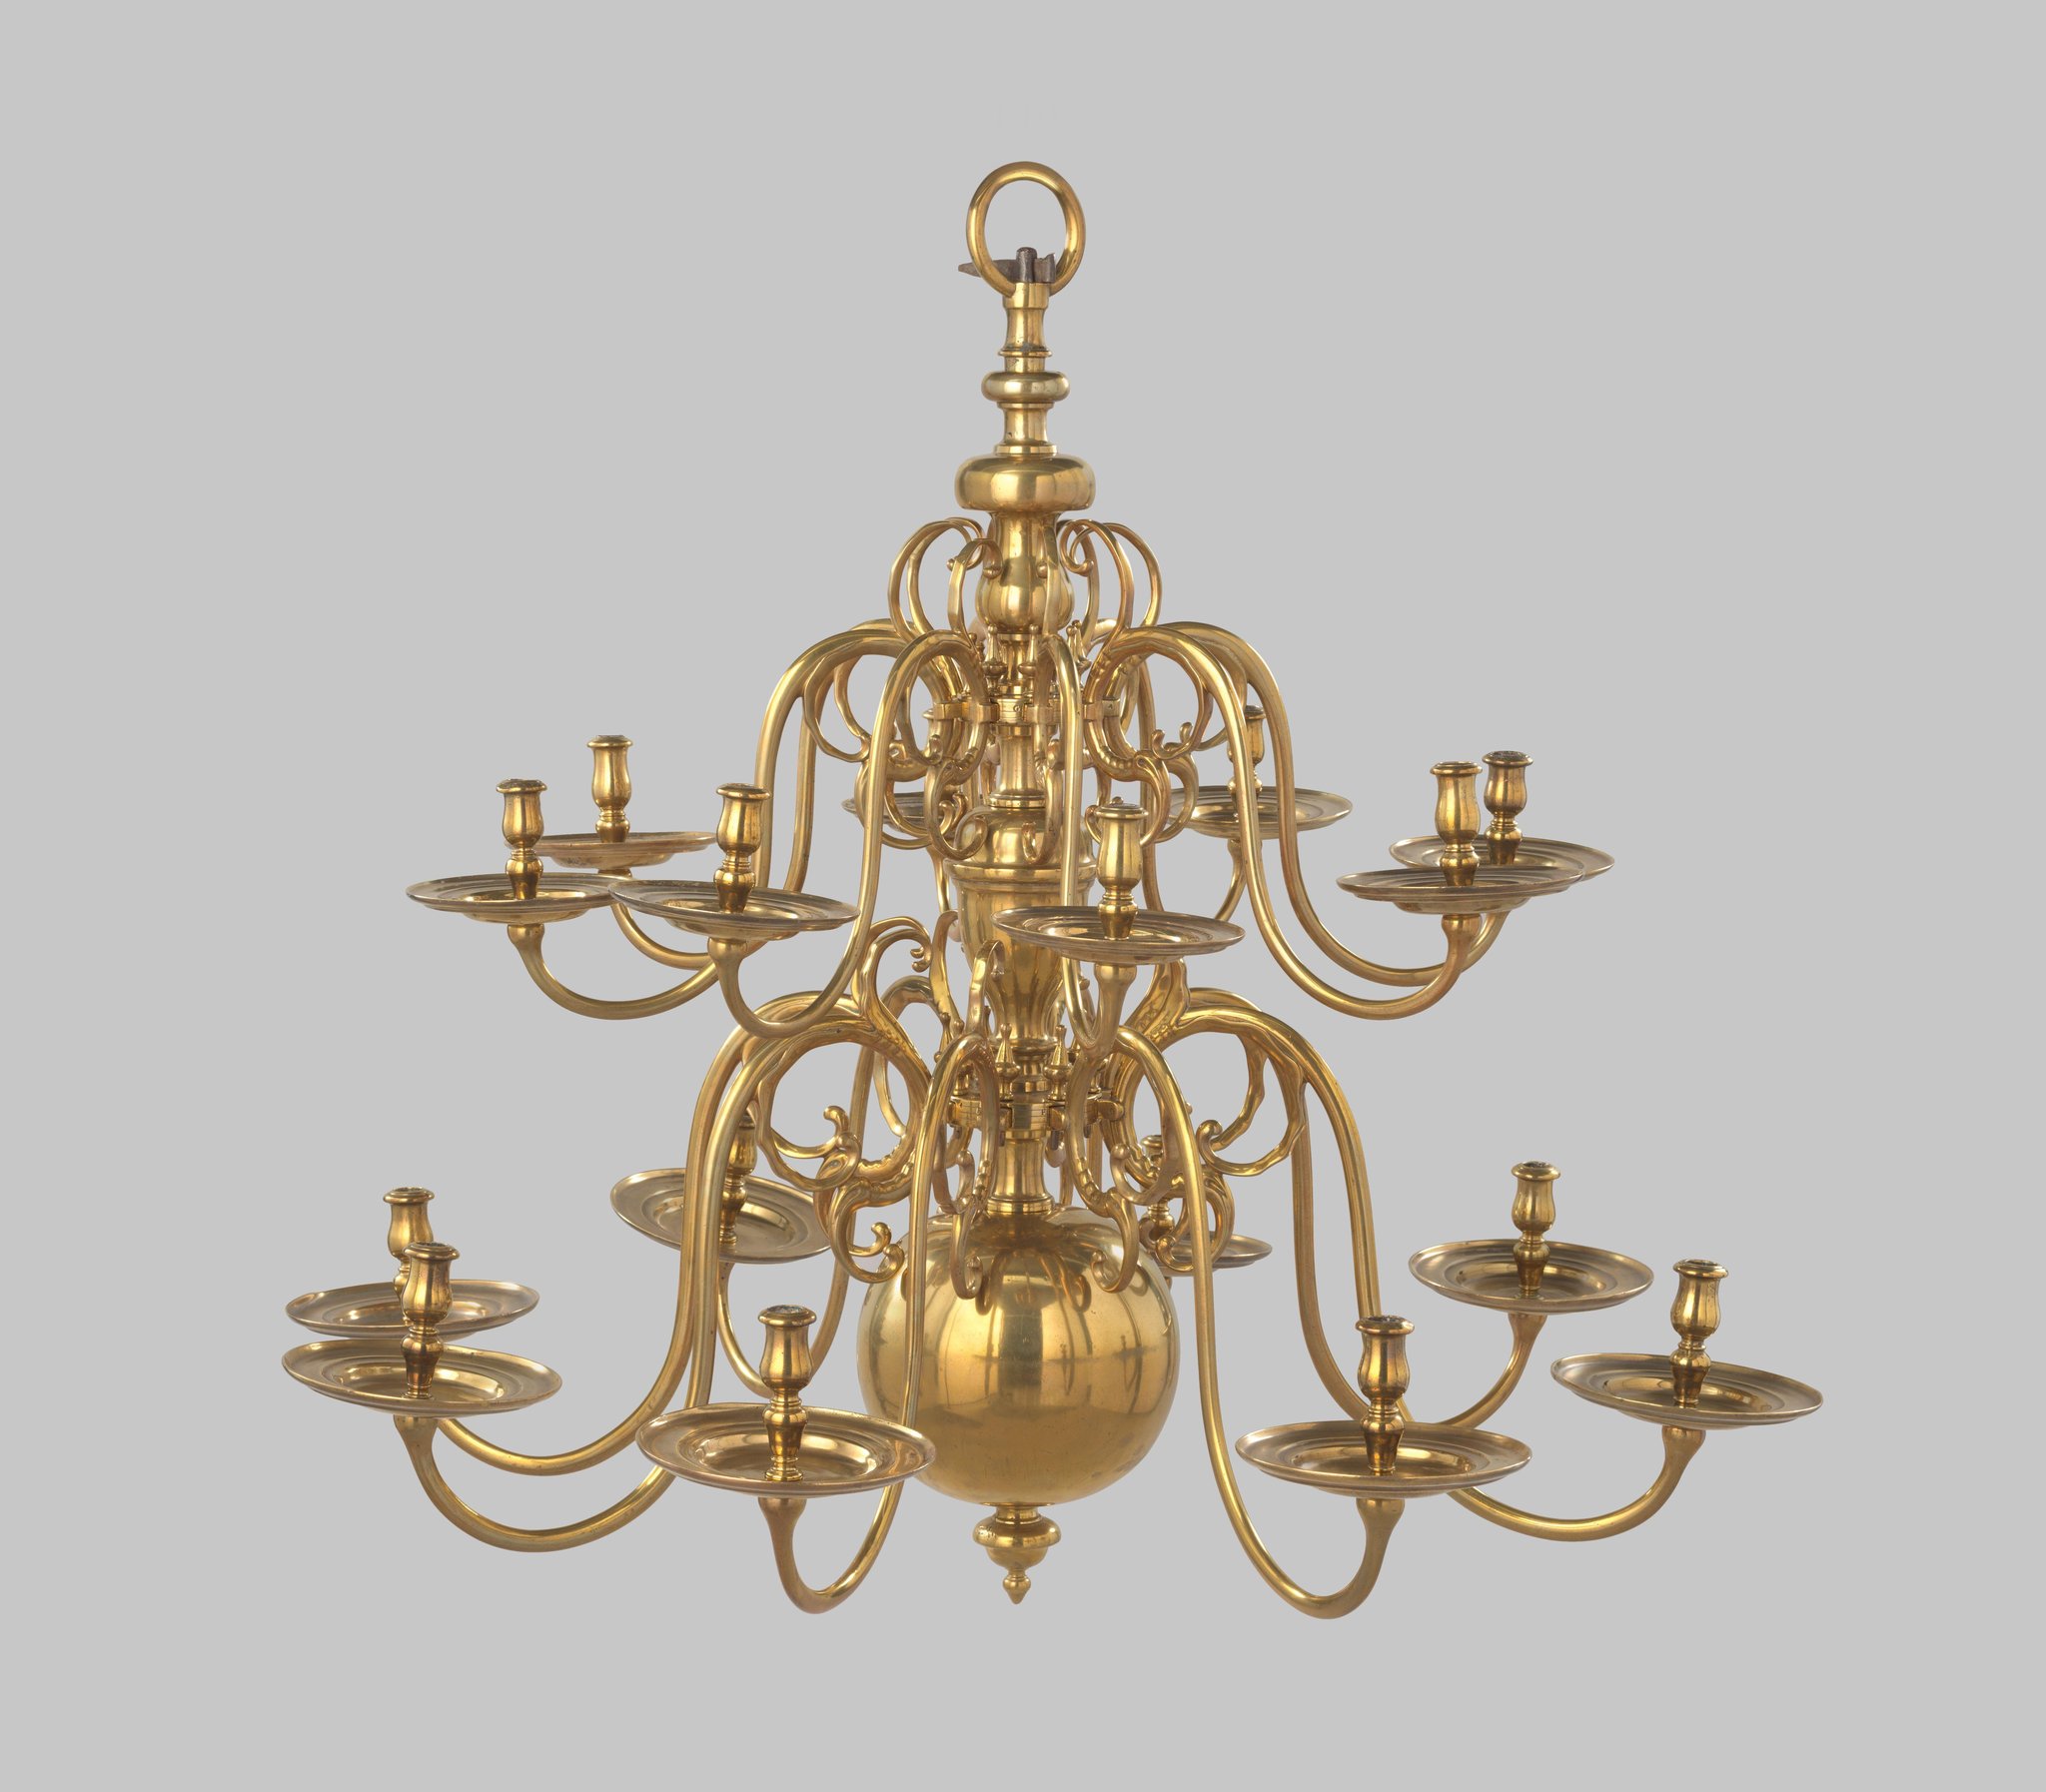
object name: chandelier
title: Arm van een kaarsenkroon in twee hoogten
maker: Anonymous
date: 1650-1675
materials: brass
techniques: screwed, turning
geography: amsterdam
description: De S-vormige arm is aan de stamzijde voorzien van een nok met een opening om deze met een pin in de standring te kunnen vastzetten. Bij de stam is de arm op het eind versierd met een gestileerde dolfijnenkop en met twee krullen, waarvan de vormgeving aan het kwabornament is ontleend. Naar buiten toe eindigt de arm in een verdikking, waarin een van een schroefdraad voorzien gat is aangebracht ter bevestiging van de kaarsenhouder met de vetvanger. De arm is met behulp van hetzelfde model gegoten als de overige armen van de krans en heeft dezelfe grootte. De kaarsenhouder heeft een ronde zich naar boven toe versmallende en in een uitstekende rand overgaande vaasvorm op balustervoet met een van een schroefdraad voorzien eind, waarin onderaan het centergat. De vetvanger is aan de bovenkant naar het midden toe één keer verdiept. Aan de onderkant is zij geprofileerd op de rand en rond het gat op het enigszins bolvormige midden. De vetvanger heeft telkens zijn eigen grootte en is met behulp van hetzelfde model gegoten als de overige vetvangers van deze krans. De pin is voorzien van een knop in vaasvorm. Dit is de zesde arm van de onderste standring, genummerd op de nok met de letter F.